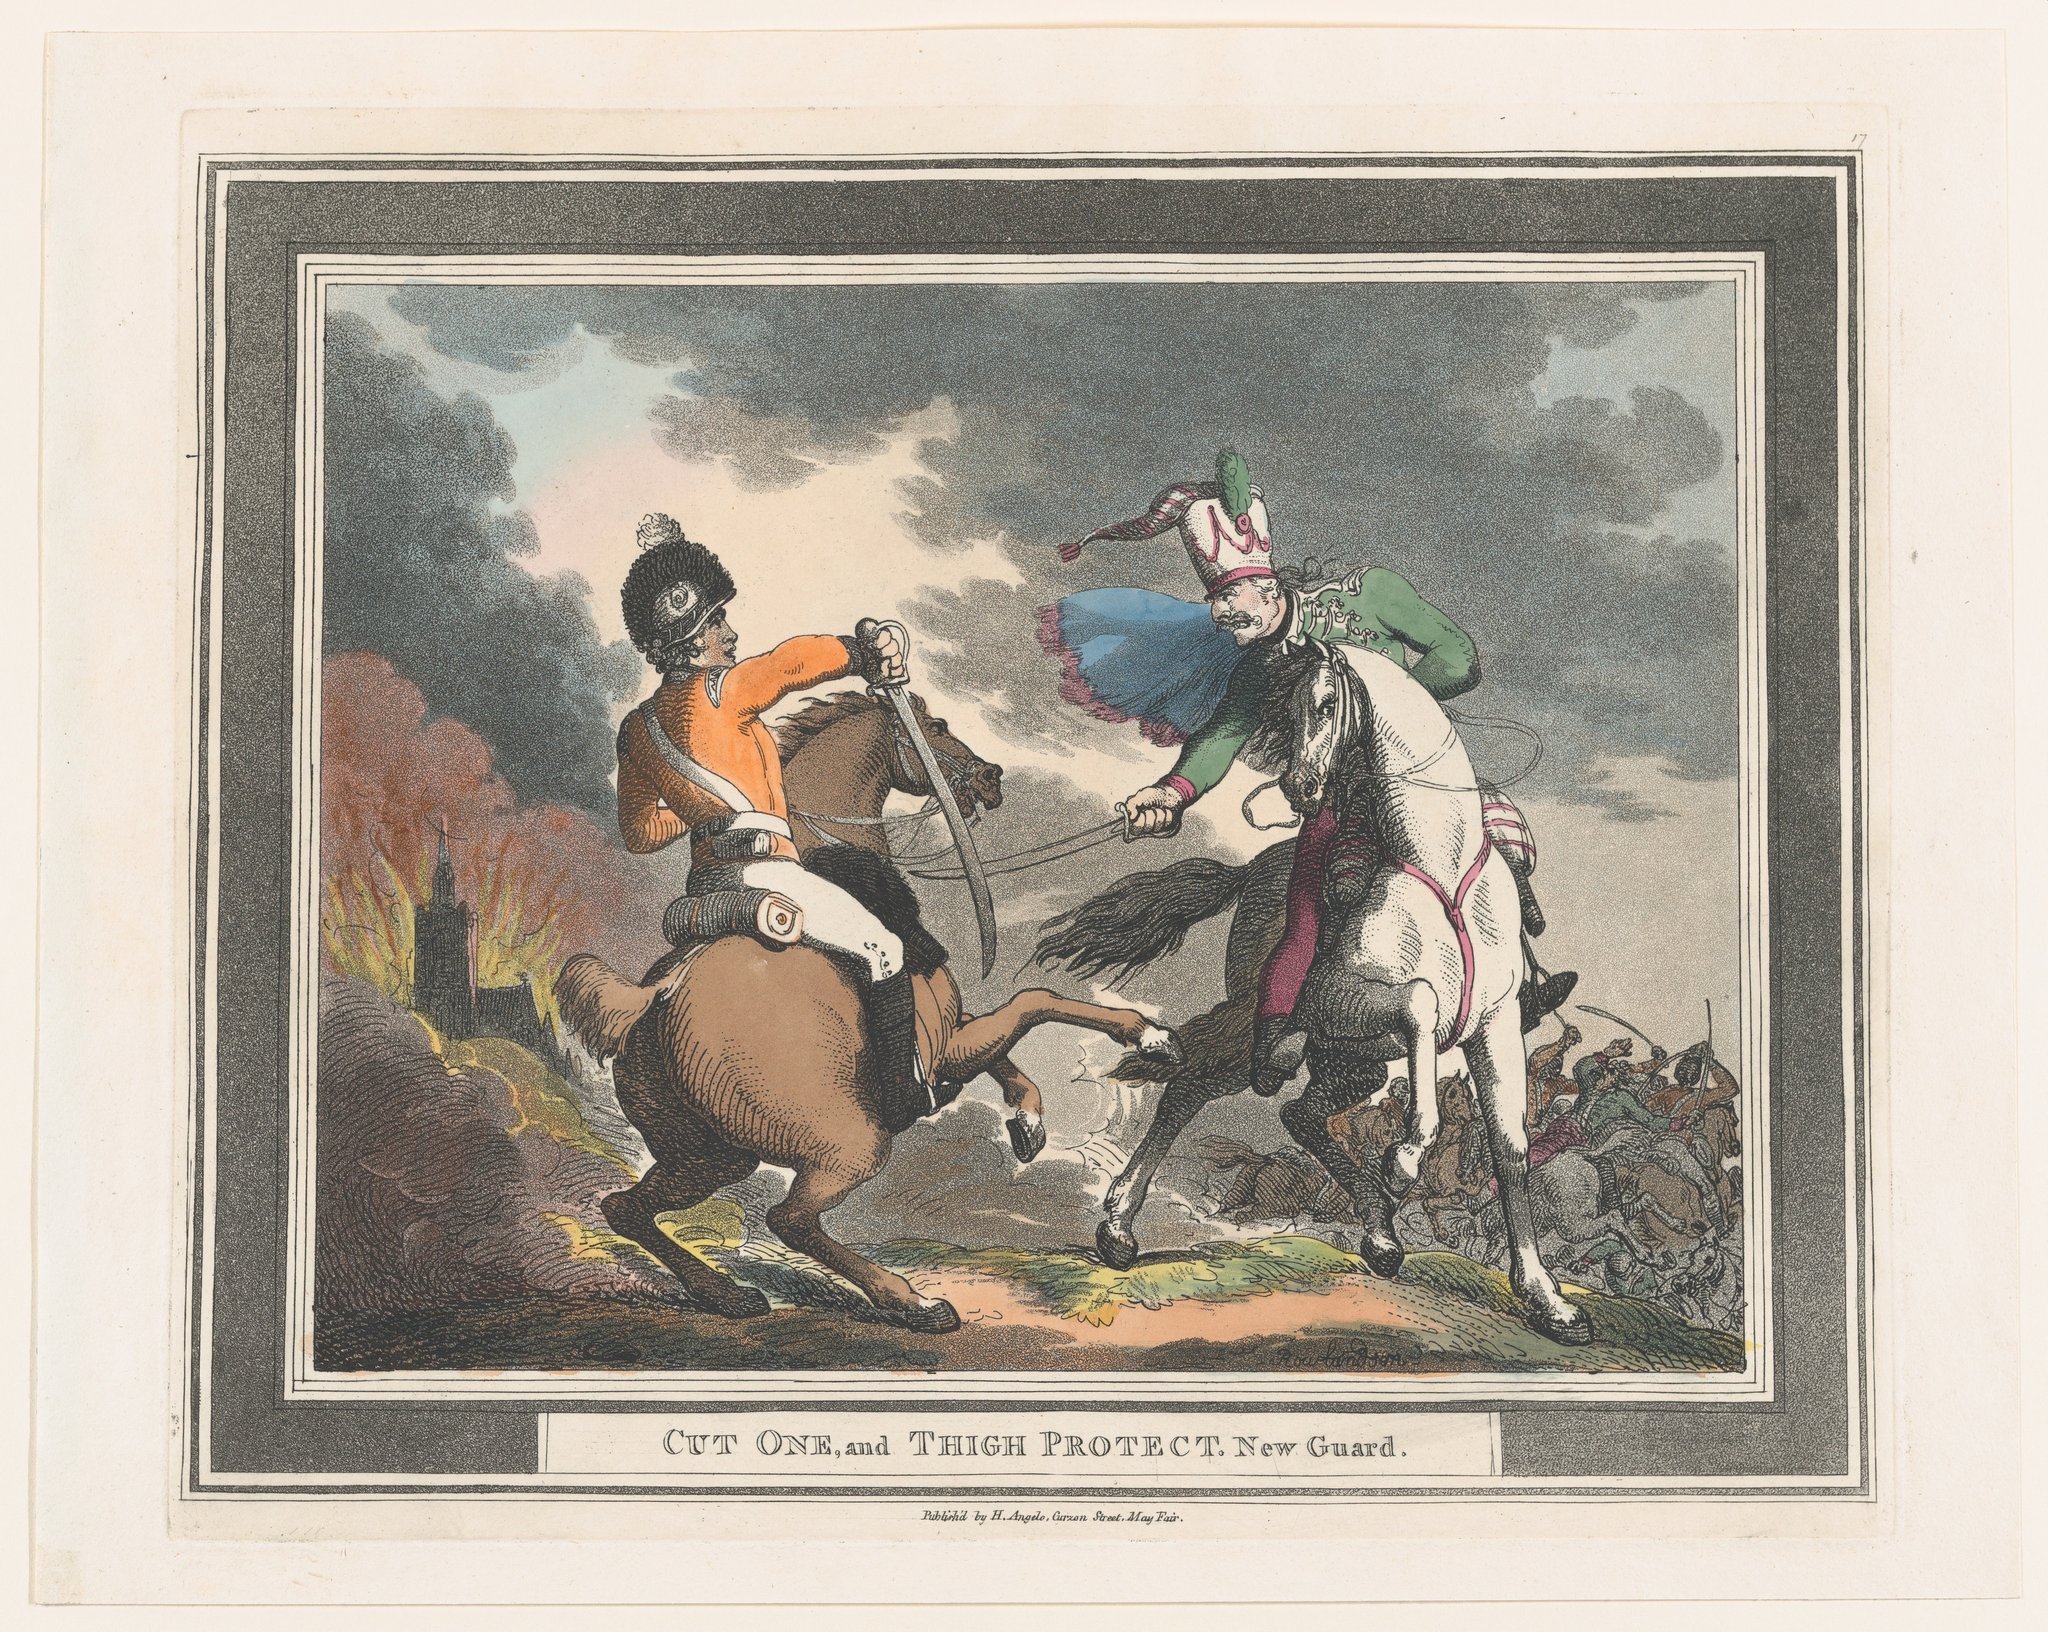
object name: print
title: Cut One and Thigh Protect New Guard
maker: thomas rowlandson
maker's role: artist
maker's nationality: british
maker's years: 1757-1827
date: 1798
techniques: aquatint, etching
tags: swords,men,horses